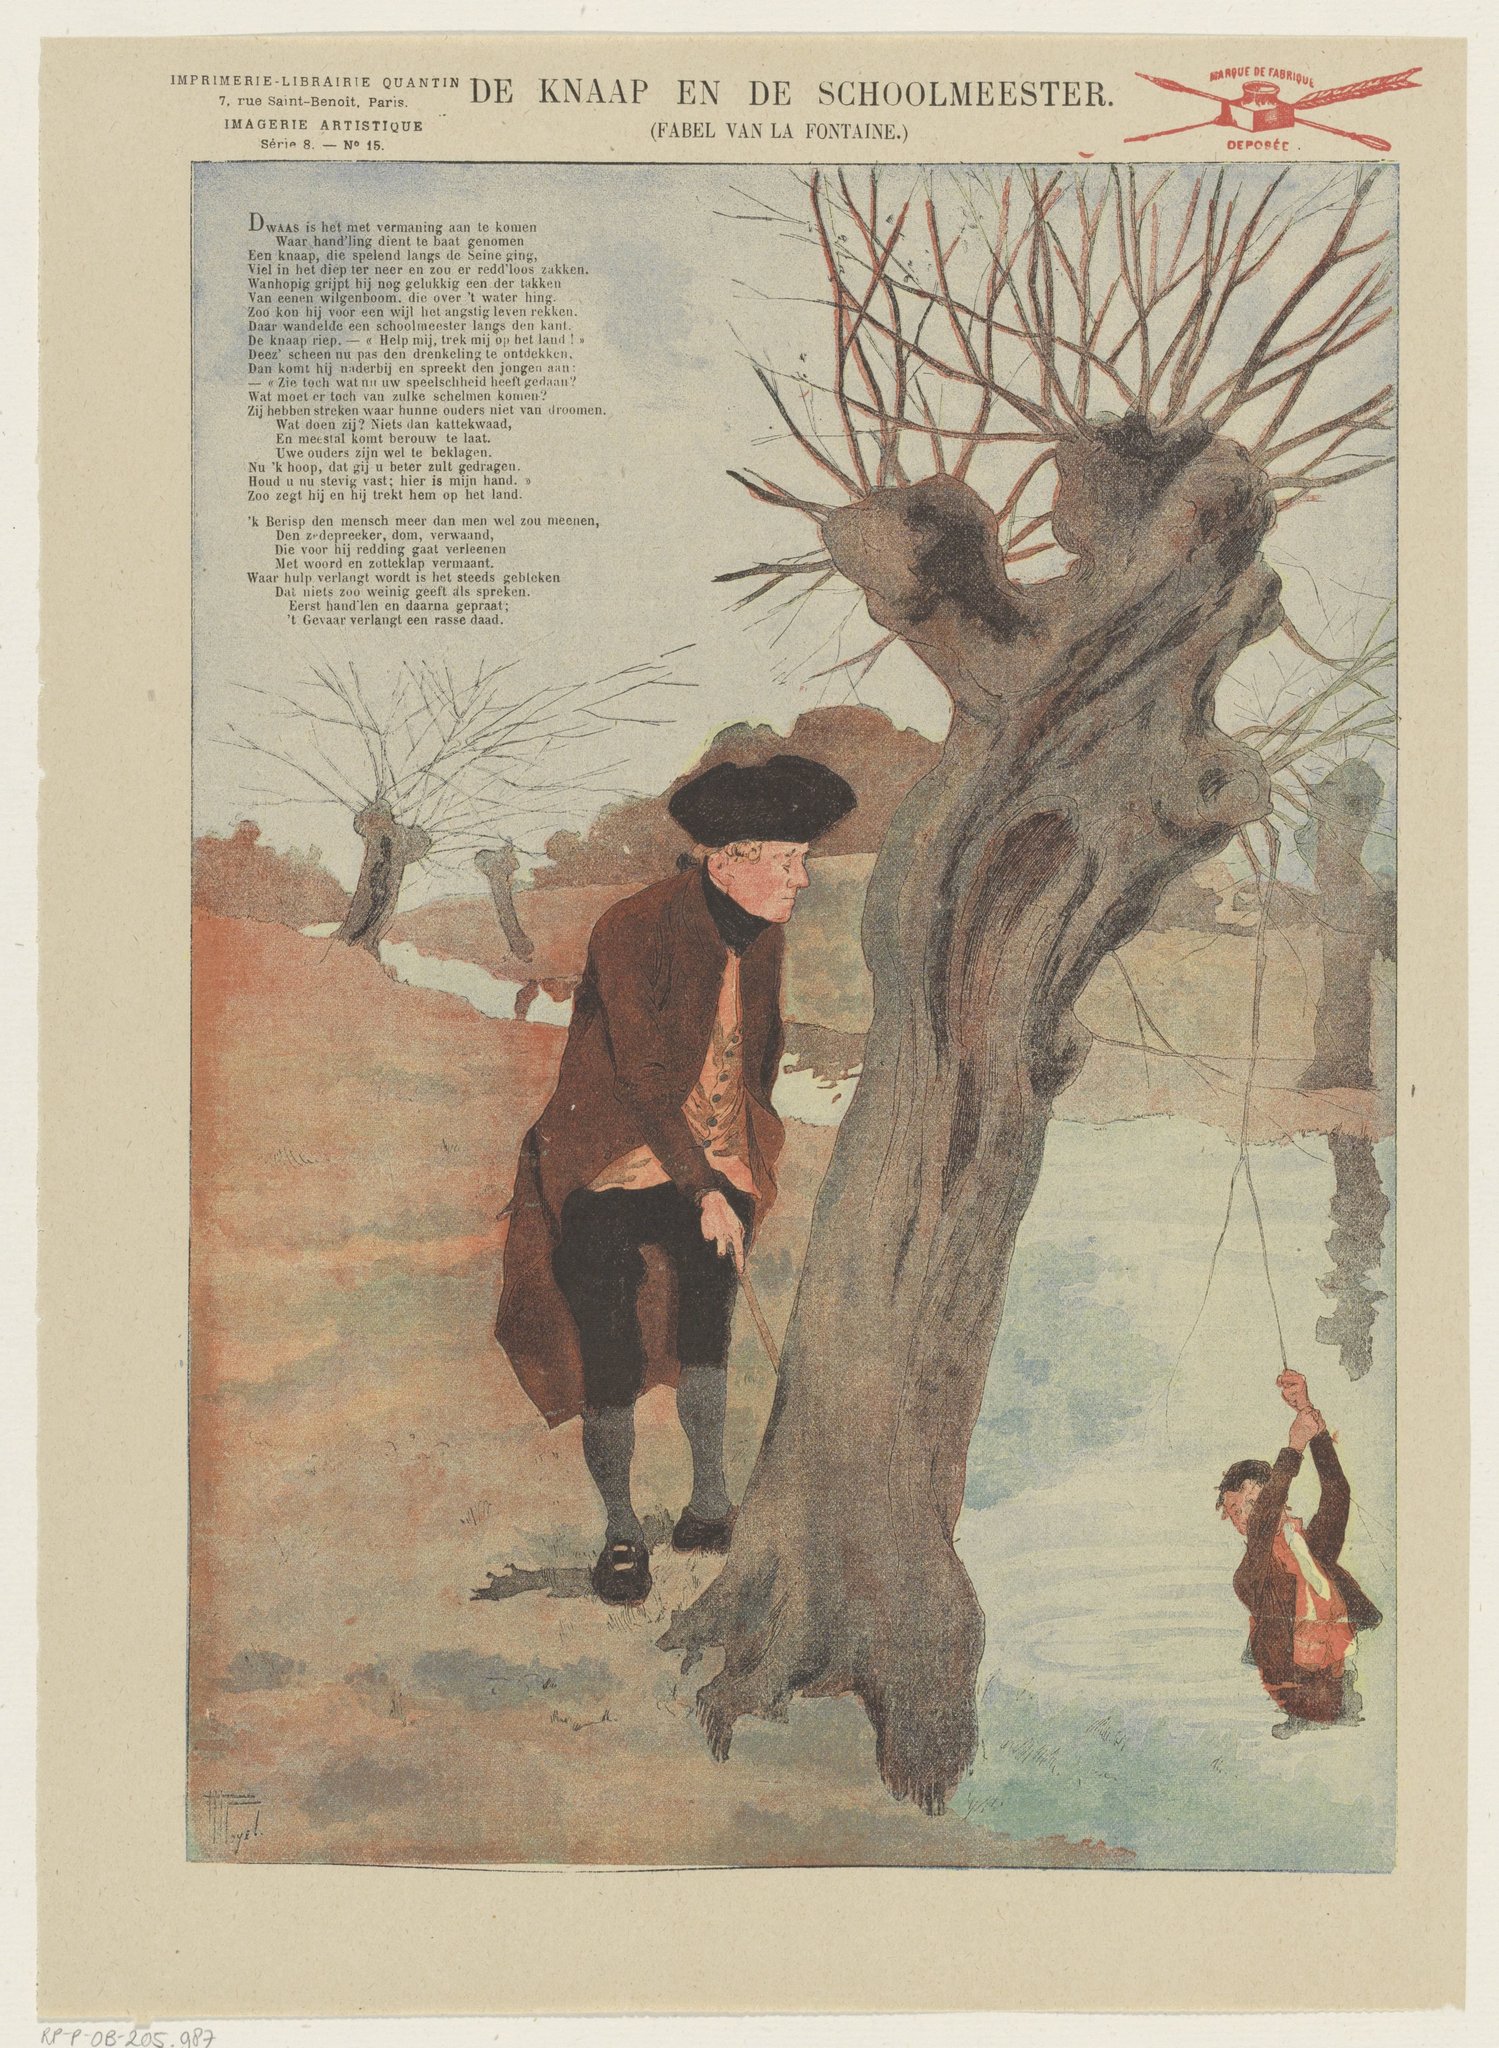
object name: print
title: Imagerie Artistique / Série 8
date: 1876-1890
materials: paper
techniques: lithograph, letterpress printing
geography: paris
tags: teacher and pupil, fables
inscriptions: : ‘marque de fabrique / deposée’, collector's mark: Lugt 2760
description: Blad met een grote voorstelling uit de fabel van Jean de La Fontaine, van de knaap en de schoolmeester. De jongen is in het water gevallen, de schoolmeester staat aan de kant. Linksboven een tekstblok met een vers. Genummerd linksboven: Série 8. - No. 15.